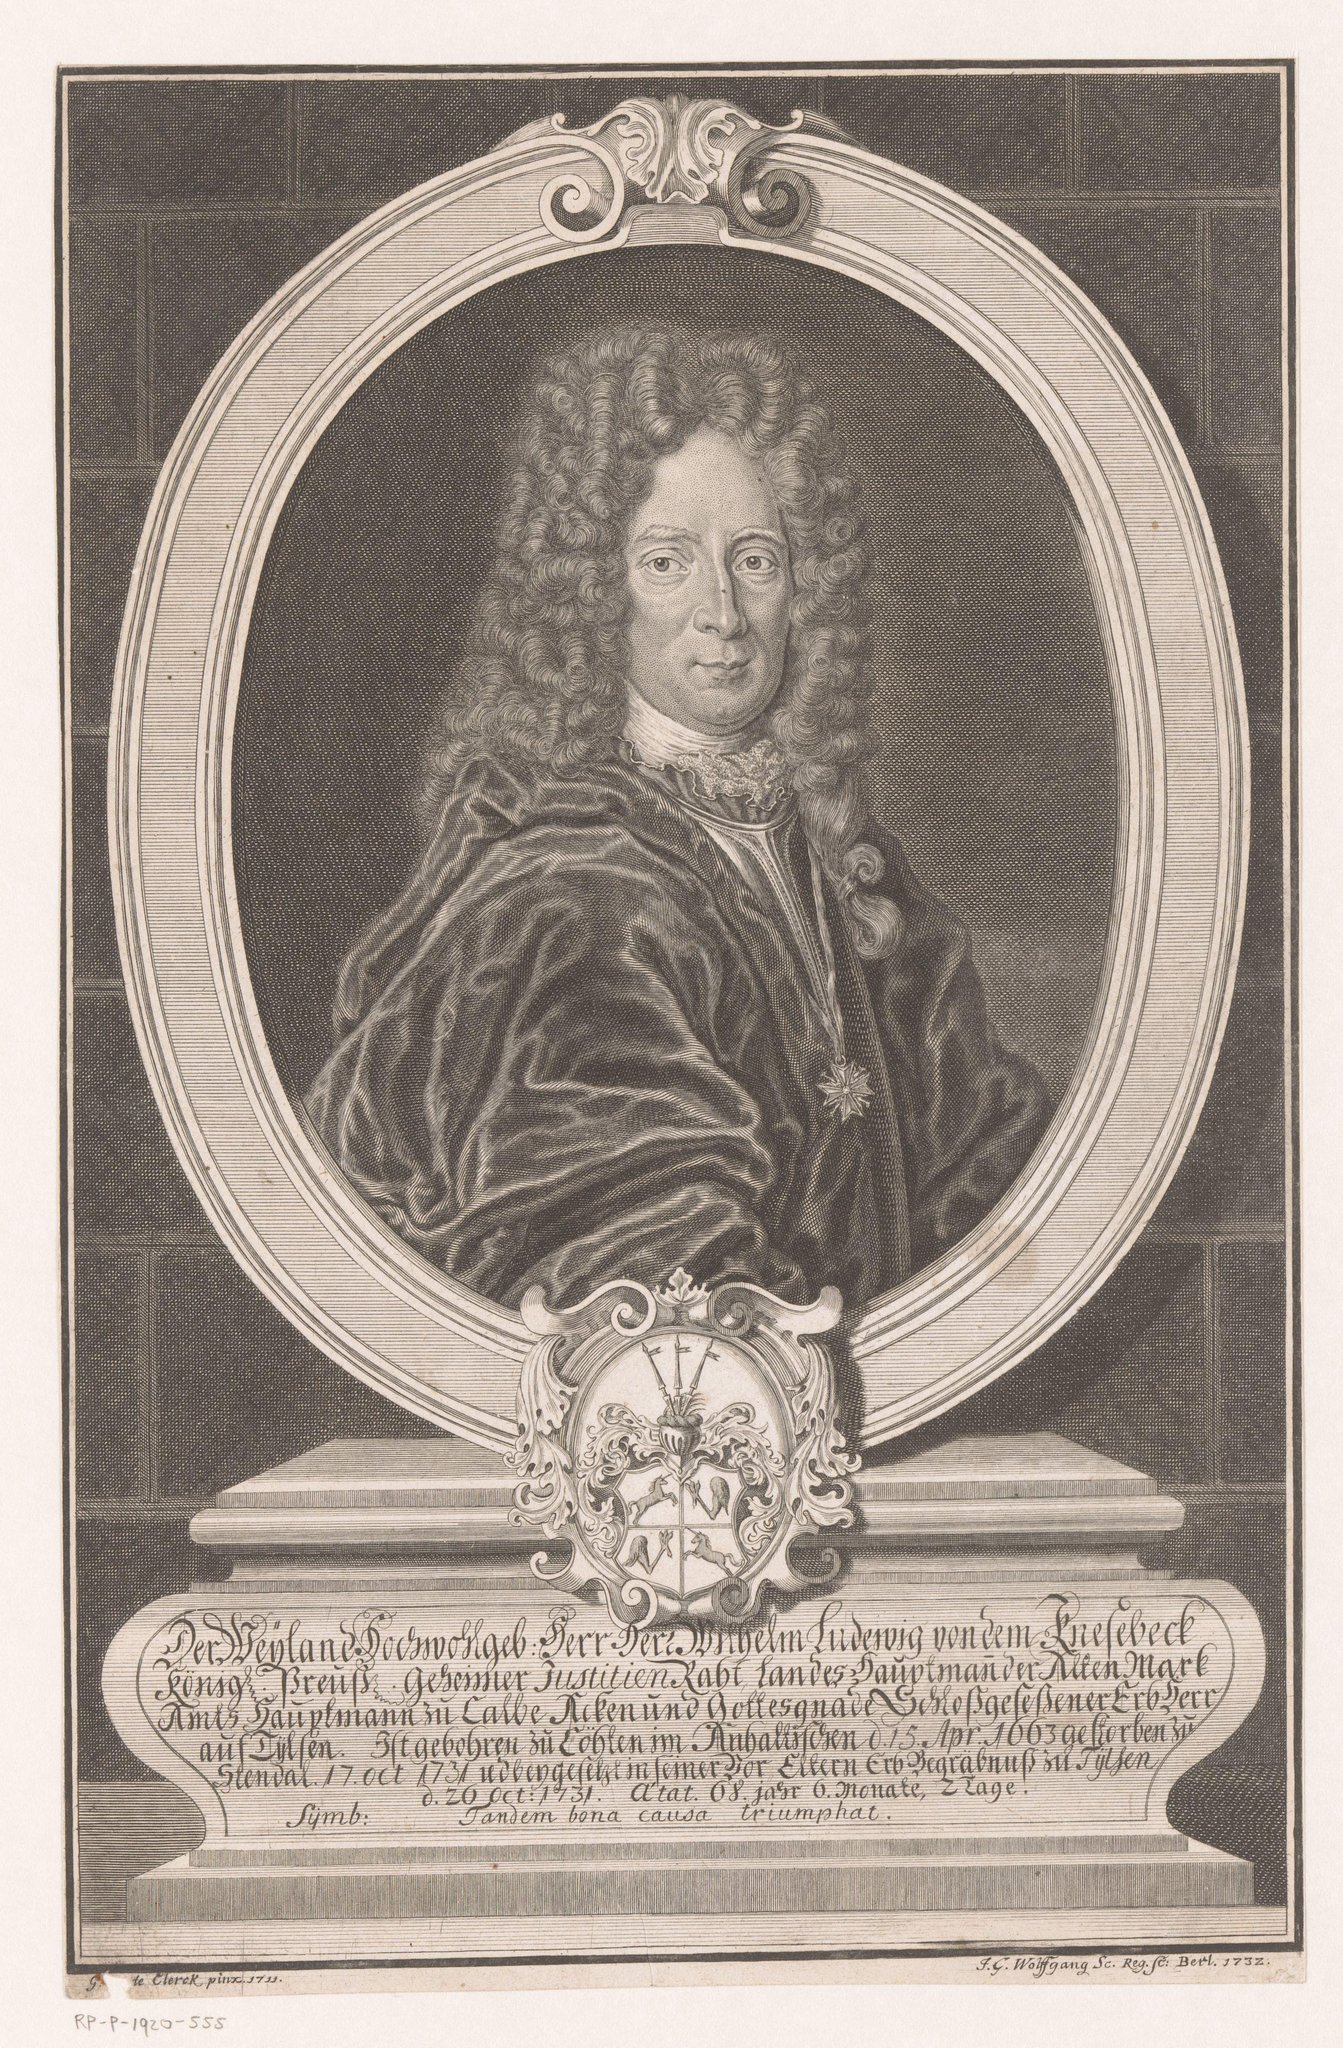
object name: print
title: Portret van Wilhelm Ludwig von dem Knesebeck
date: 1732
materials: paper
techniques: engraving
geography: berlin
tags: historical persons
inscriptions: collector's mark: Lugt 2228